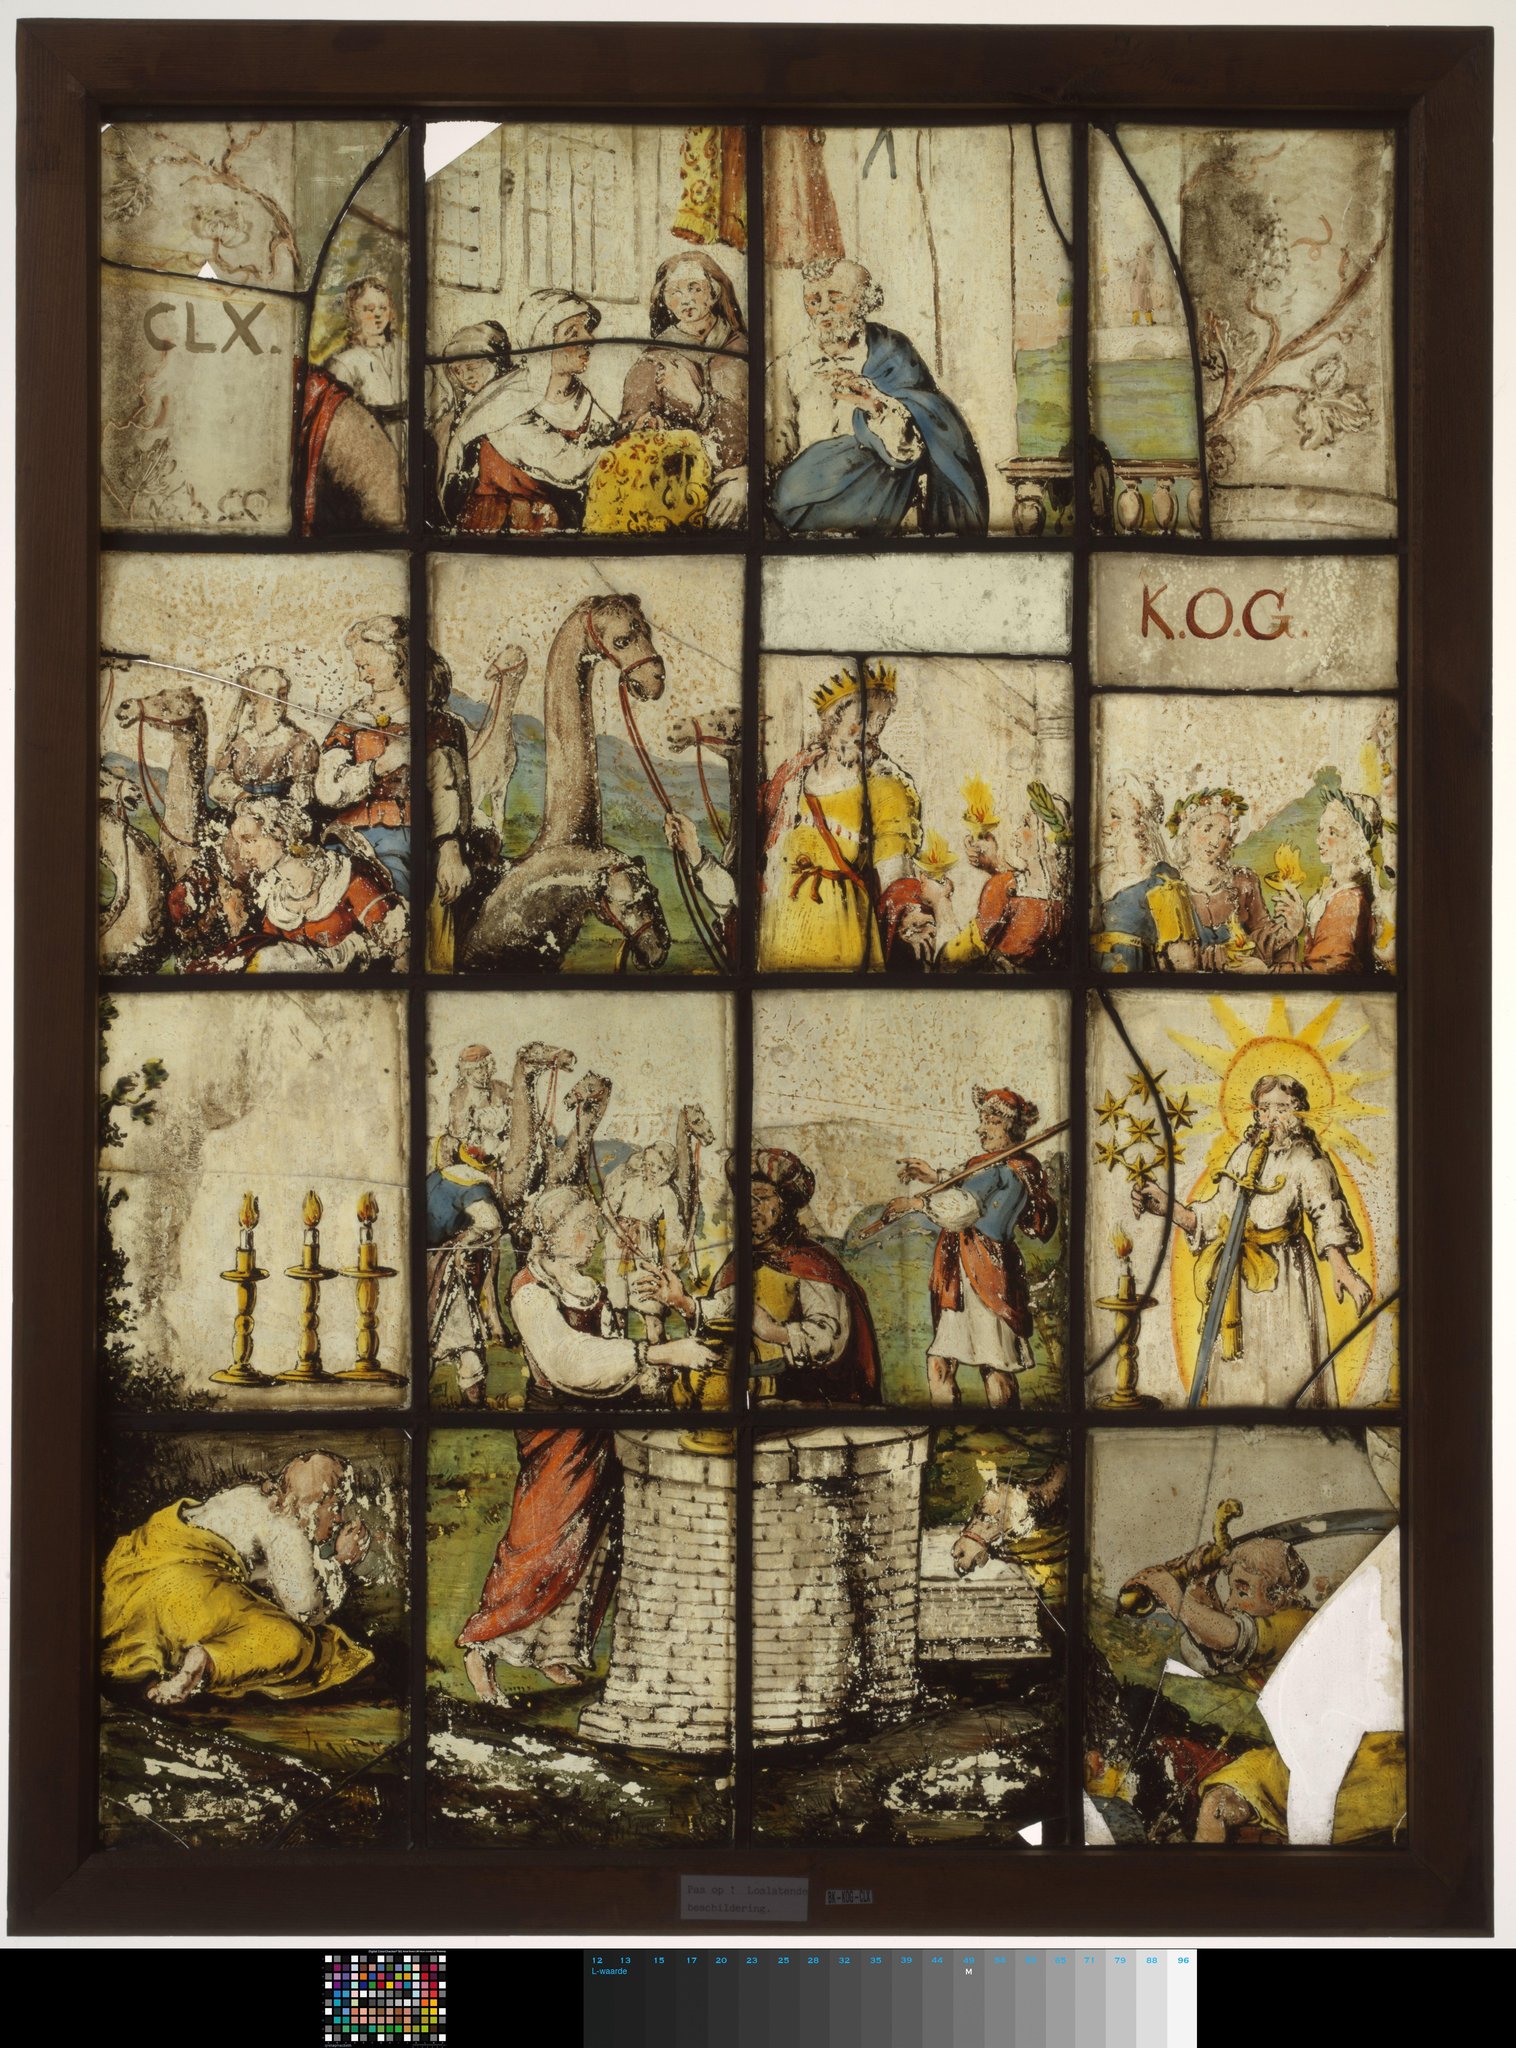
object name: light window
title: Paneel waarin twintig ruiten met diverse fragmenten van taferelen uit het Oude Testament en het Leven der Heiligen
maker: Anonymous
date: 1600-1700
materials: glass, lead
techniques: leading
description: Paneel waarin 20 ruiten met diverse fragmenten van taferelen uit het Oude Testament en het leven der heiligen.